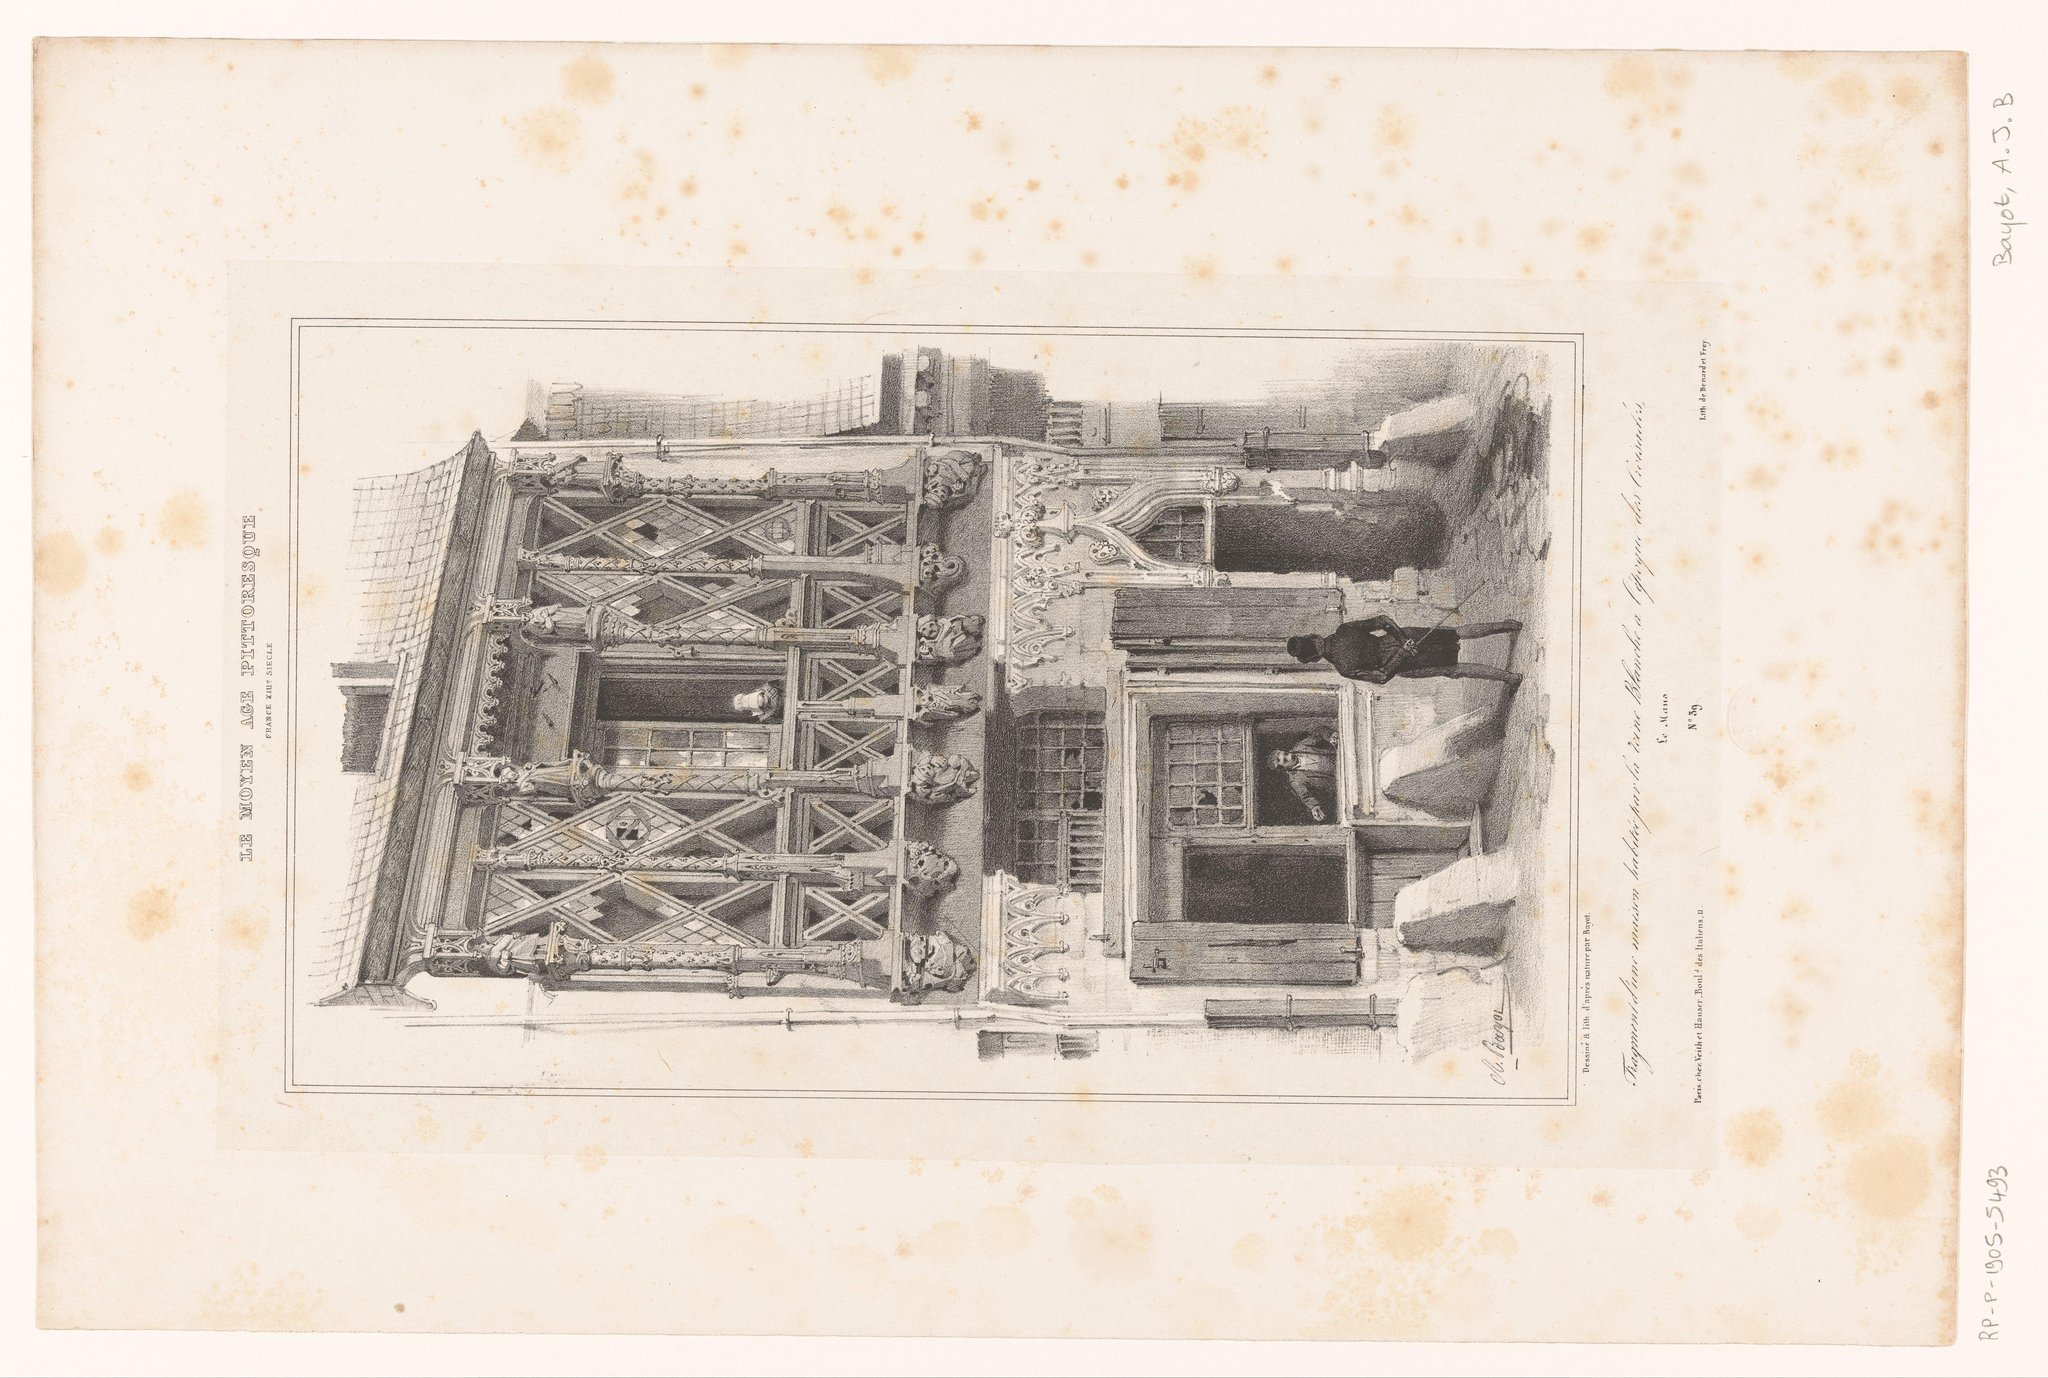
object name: print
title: Fragment d'une maison habitée par la reine Blanche à l'époque des croisades, Le Mans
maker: adolphe jean baptiste bayot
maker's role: print maker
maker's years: 1810-1866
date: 1837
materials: paper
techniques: lithograph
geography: paris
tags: façade (of house or building)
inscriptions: collector's mark: Lugt 2228a, check stamp: Lugt 4619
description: Het huis dankt zijn naam aan Bérengère de Navarre (1163-1230), de vrouw van Richard Leeuwenhart.